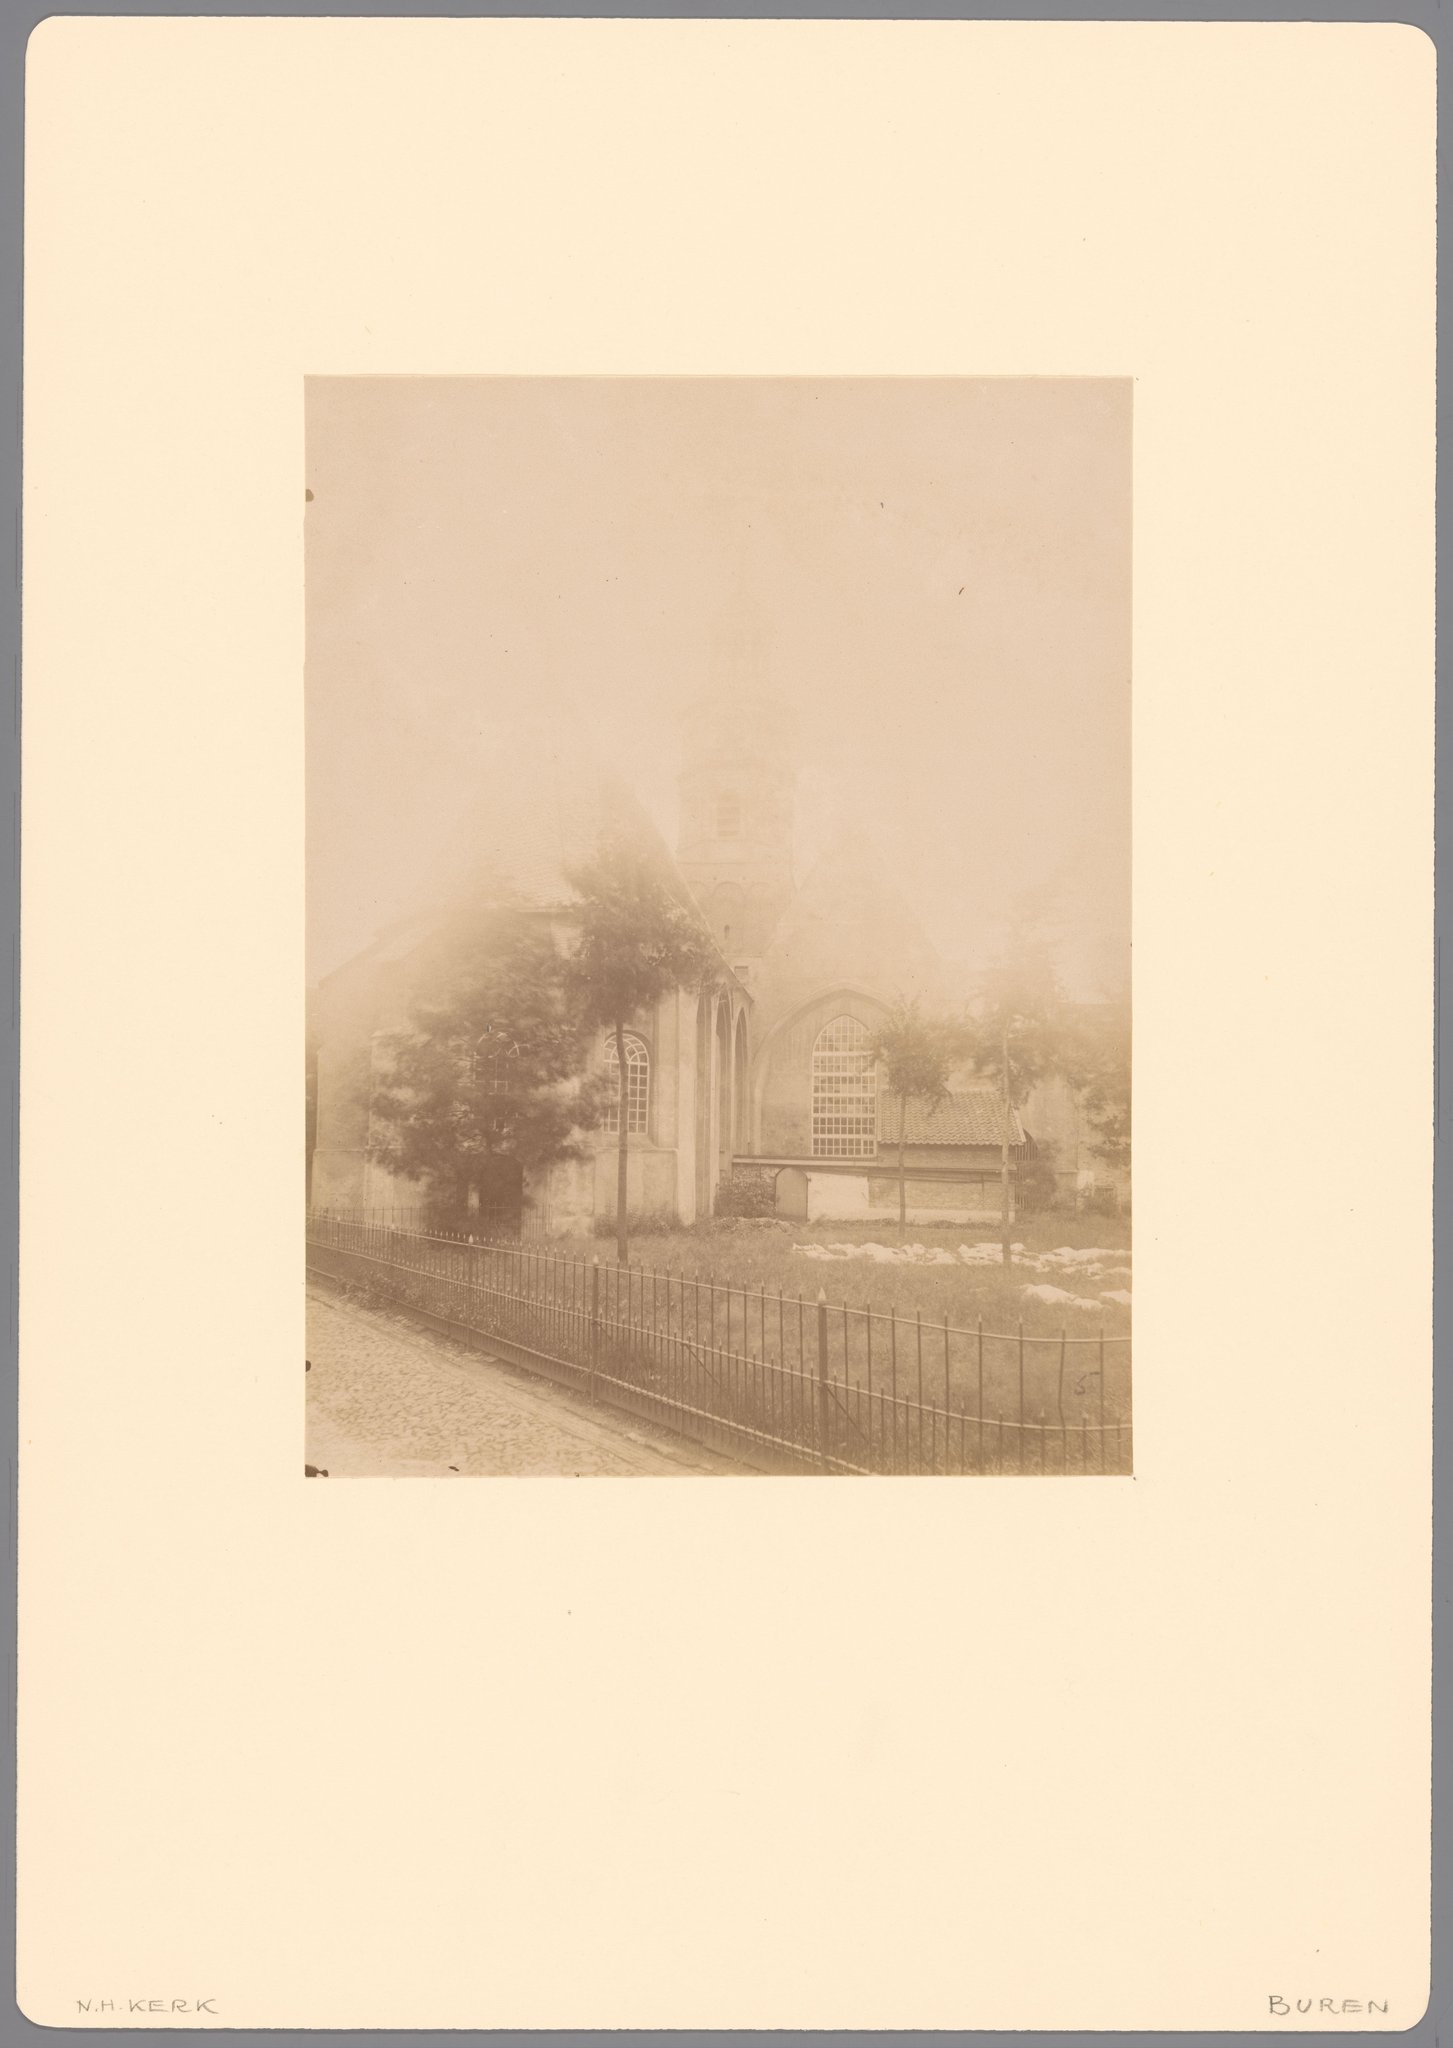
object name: photograph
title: Gezicht op de Sint-Lambertuskerk te Buren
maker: anoniem (monumentenzorg)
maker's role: fotograaf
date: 1890-1920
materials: cardboard, photographic support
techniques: albumen print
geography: buren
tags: church (exterior)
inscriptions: annotation: ‘N.H. Kerk/ Buren’, annotation: ‘Buren/ N.H. Kerk’